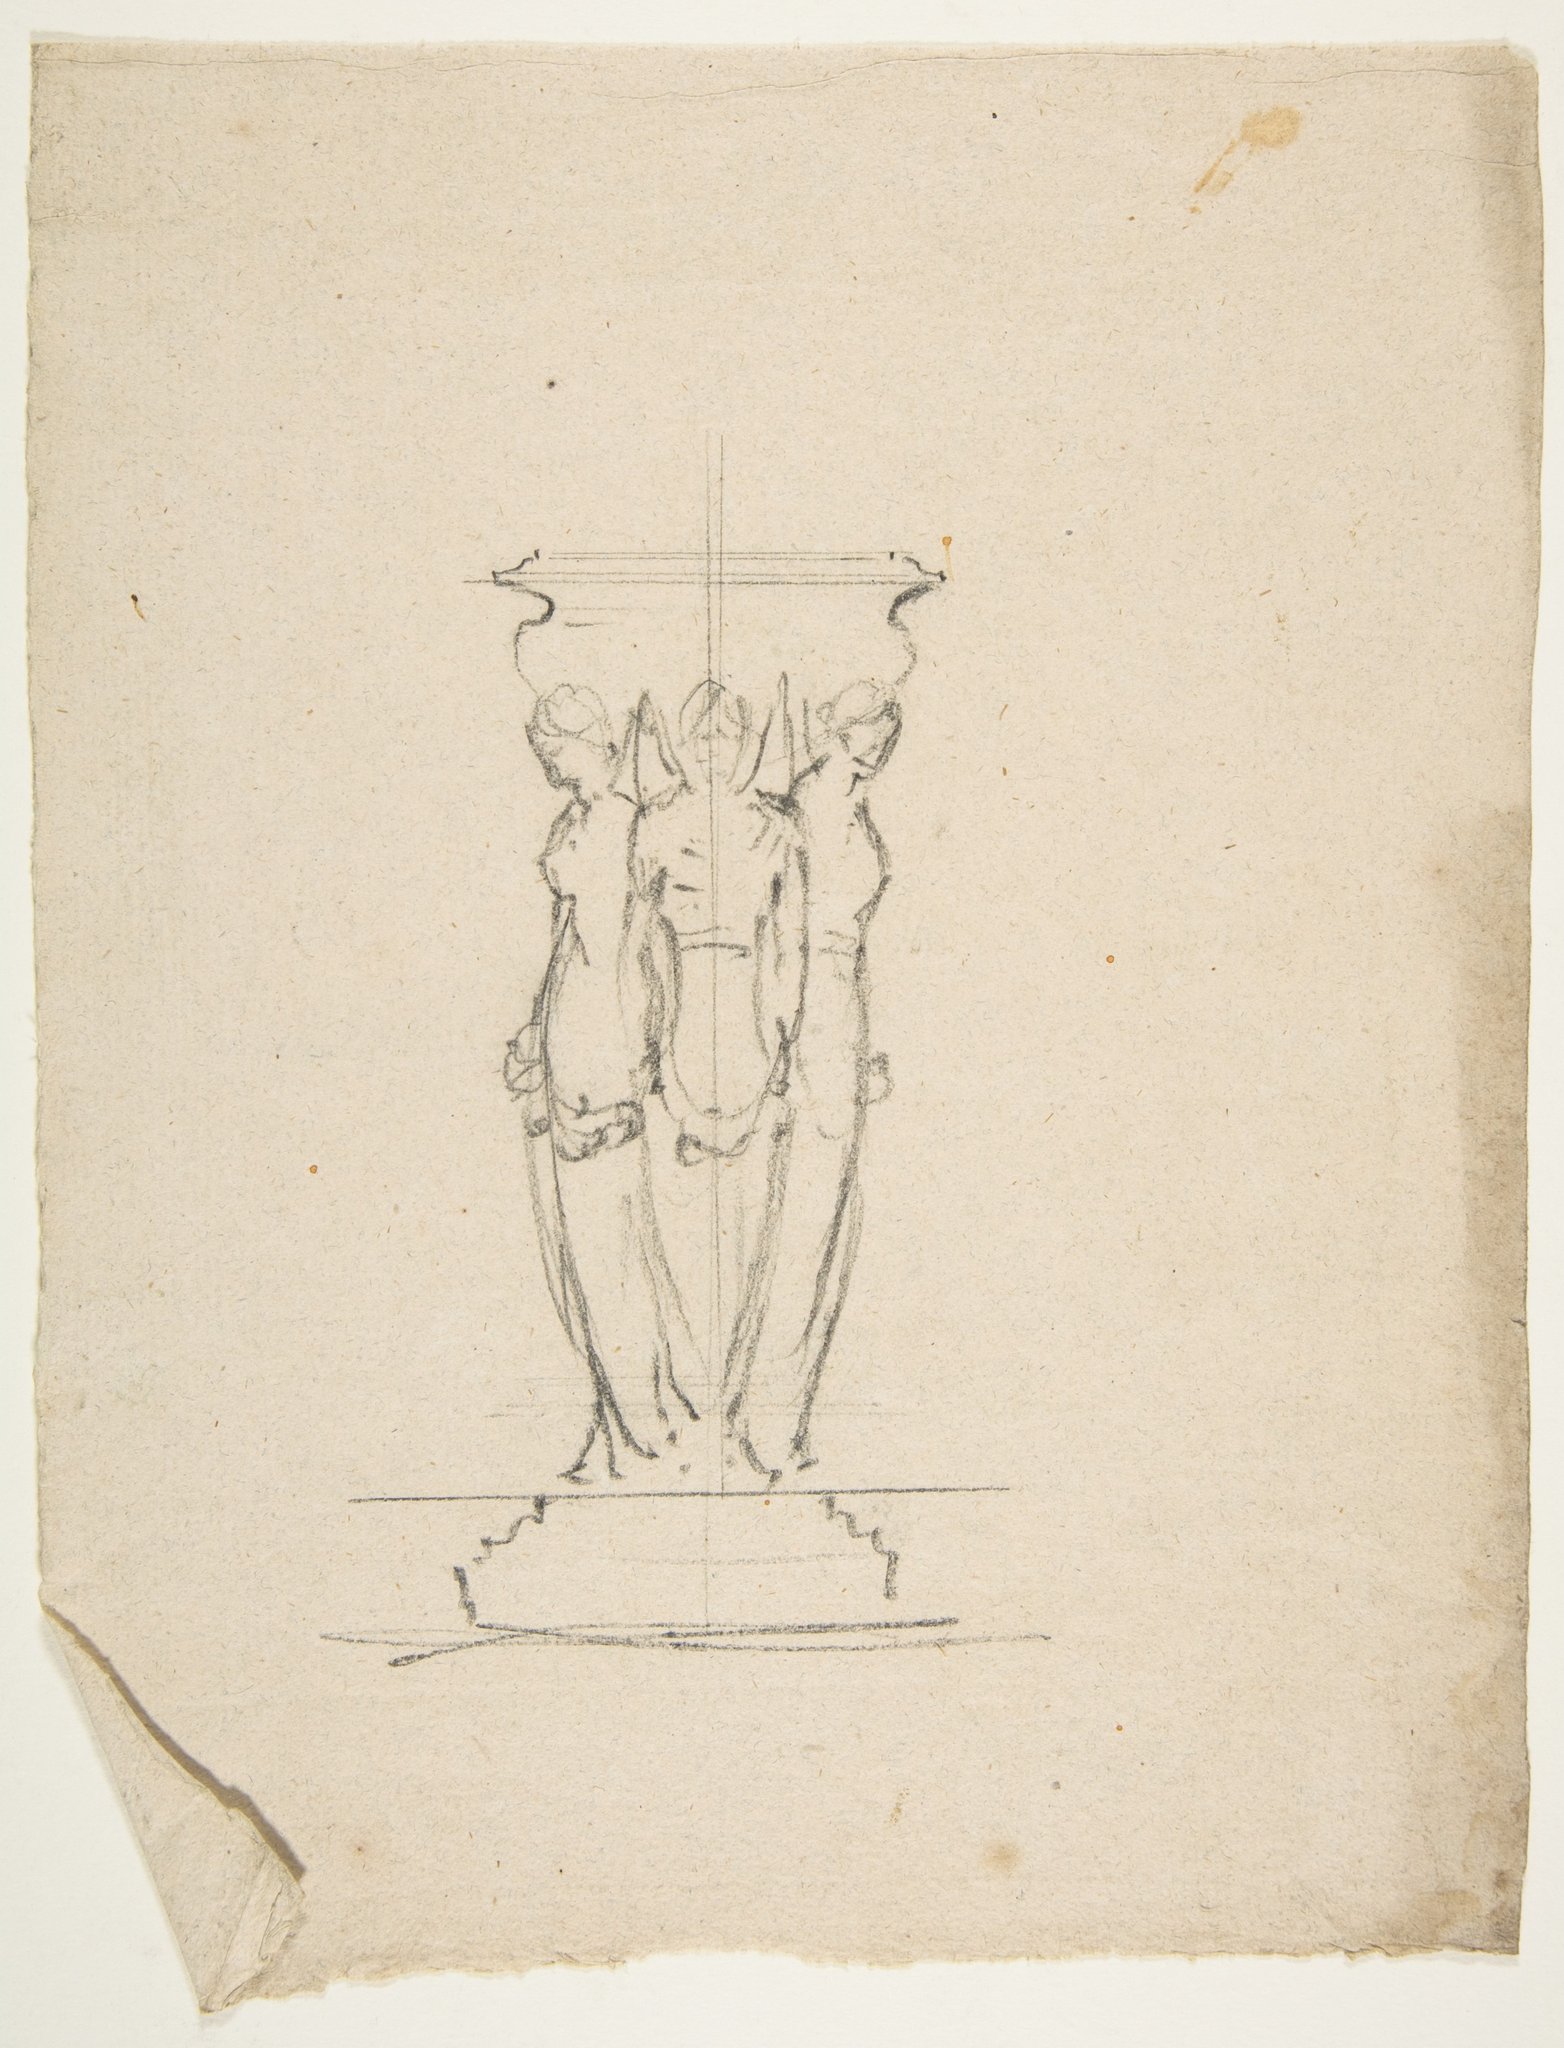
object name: drawing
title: Desing for a base or support with three female figures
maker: anonymous, french, 19th century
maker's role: artist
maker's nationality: french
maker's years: 1800-1900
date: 1801-1900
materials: chalk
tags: women